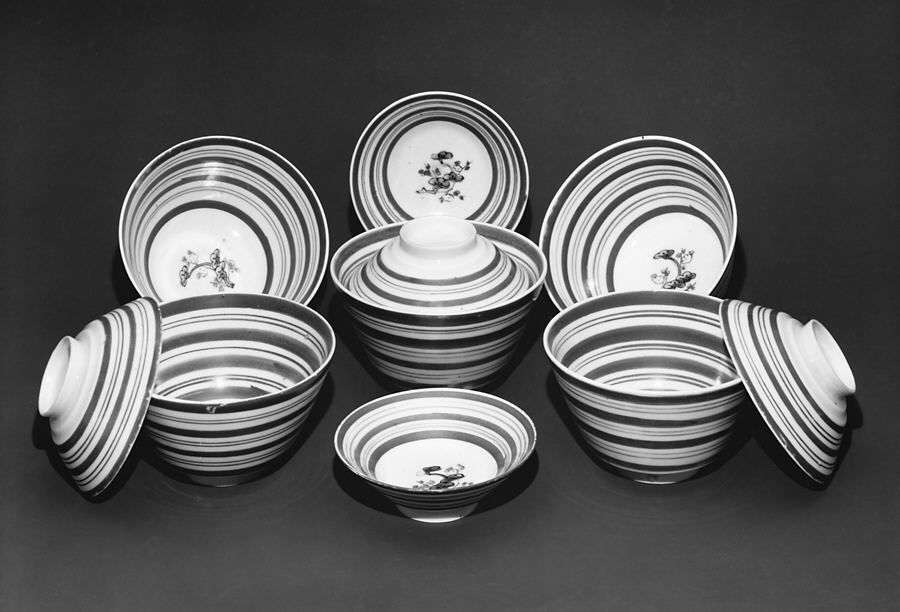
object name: covered bowl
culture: japanese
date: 1701-1800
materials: porcelain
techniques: underglaze